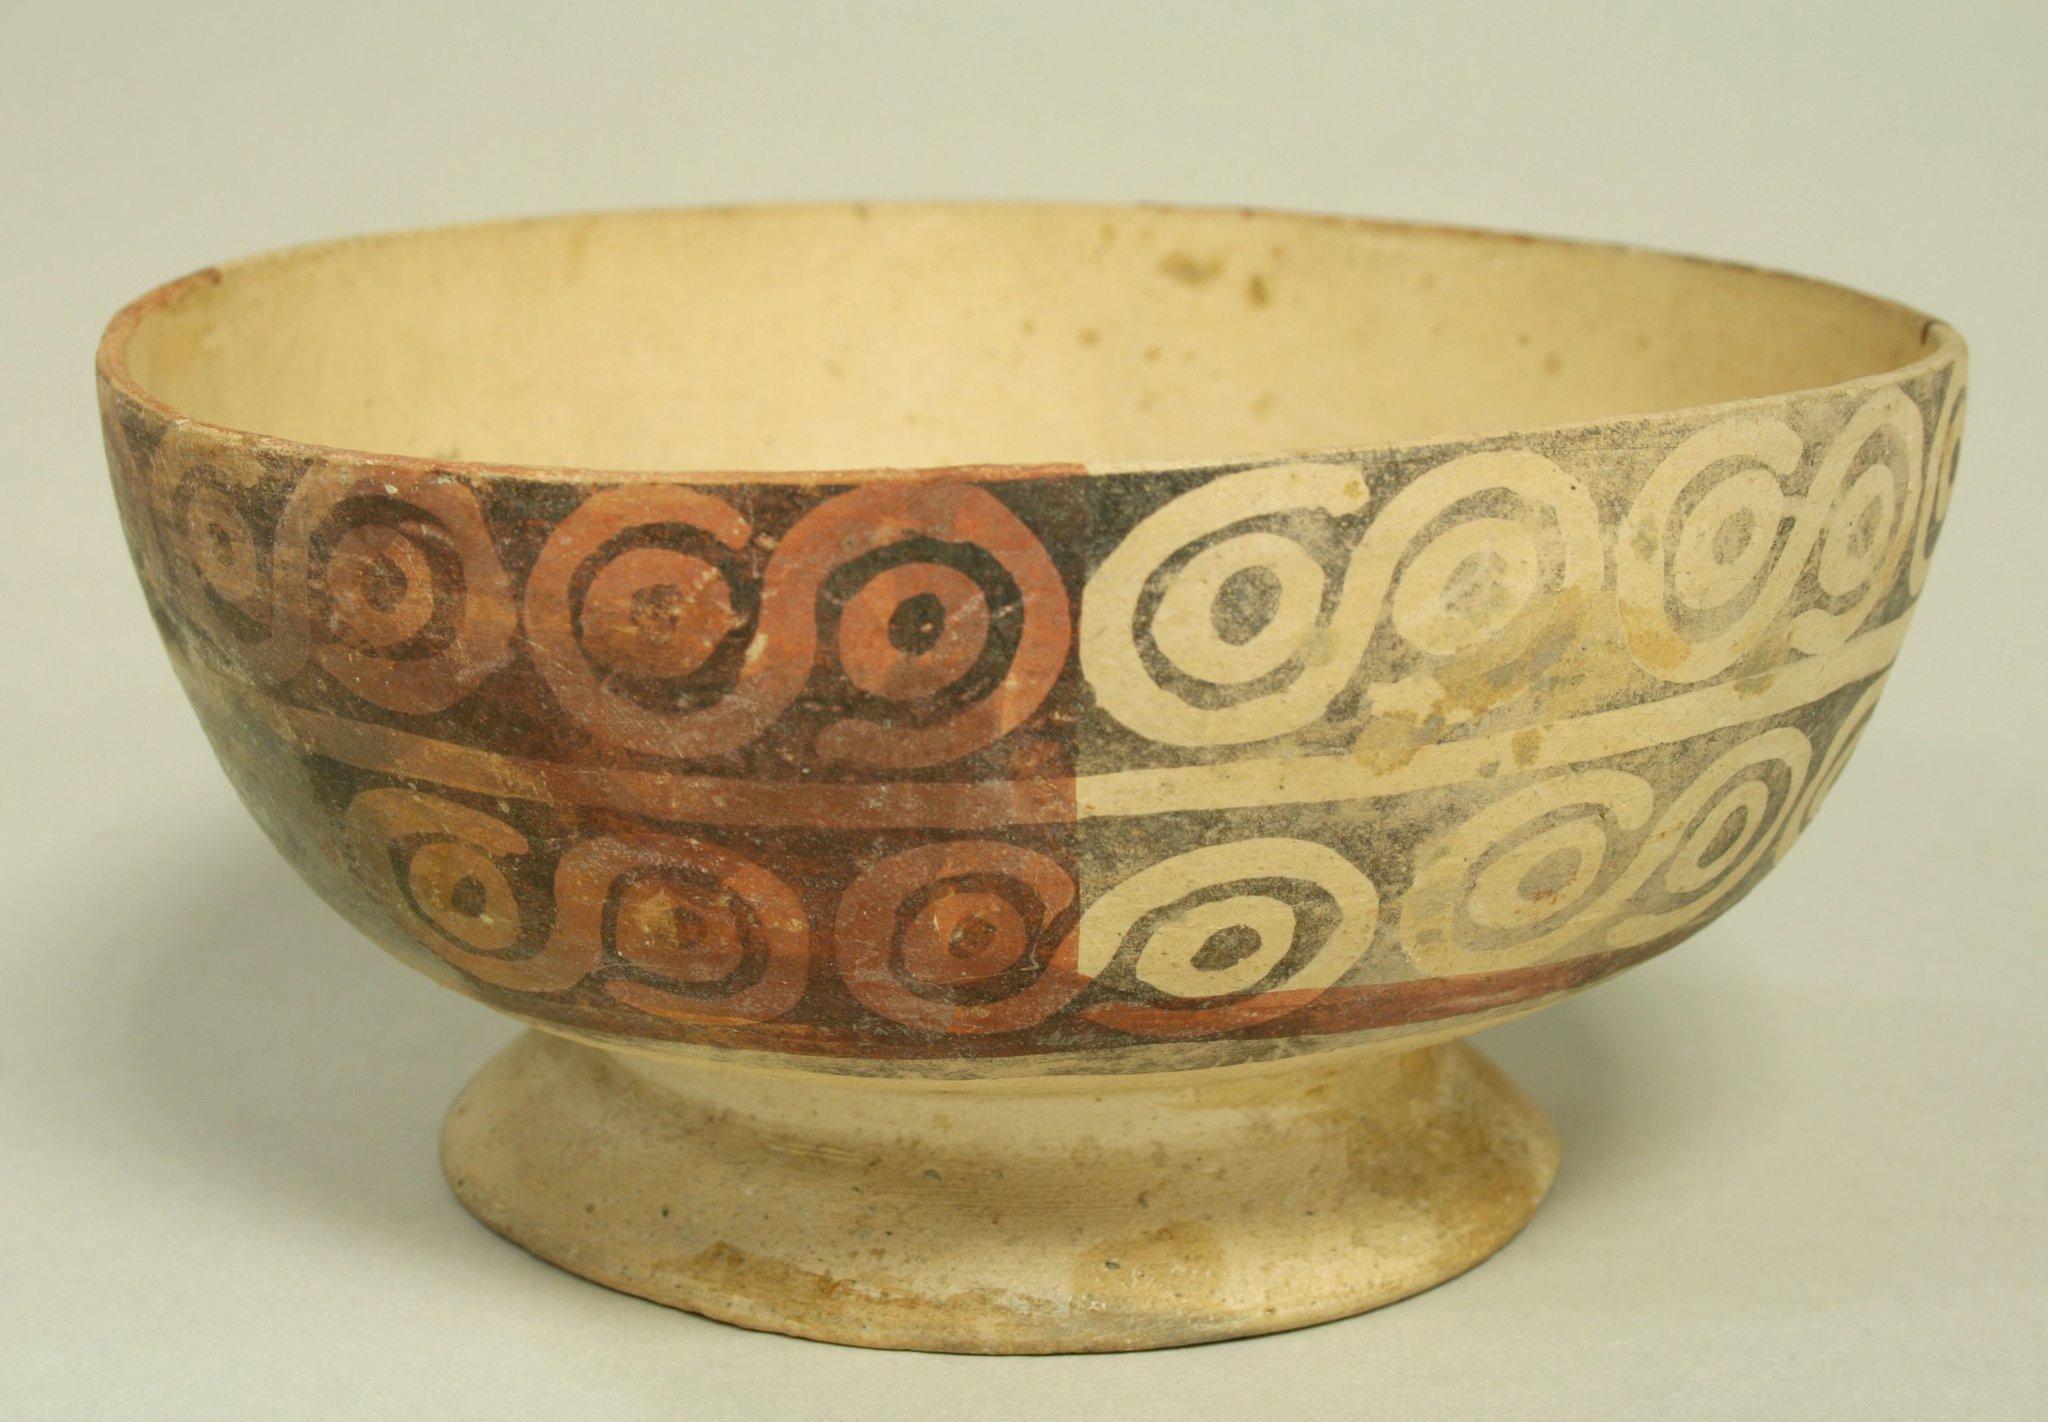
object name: bowl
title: Pedestal Bowl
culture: recuay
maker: recuay artist(s)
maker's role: artist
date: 200-700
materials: ceramic, pigment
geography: peru